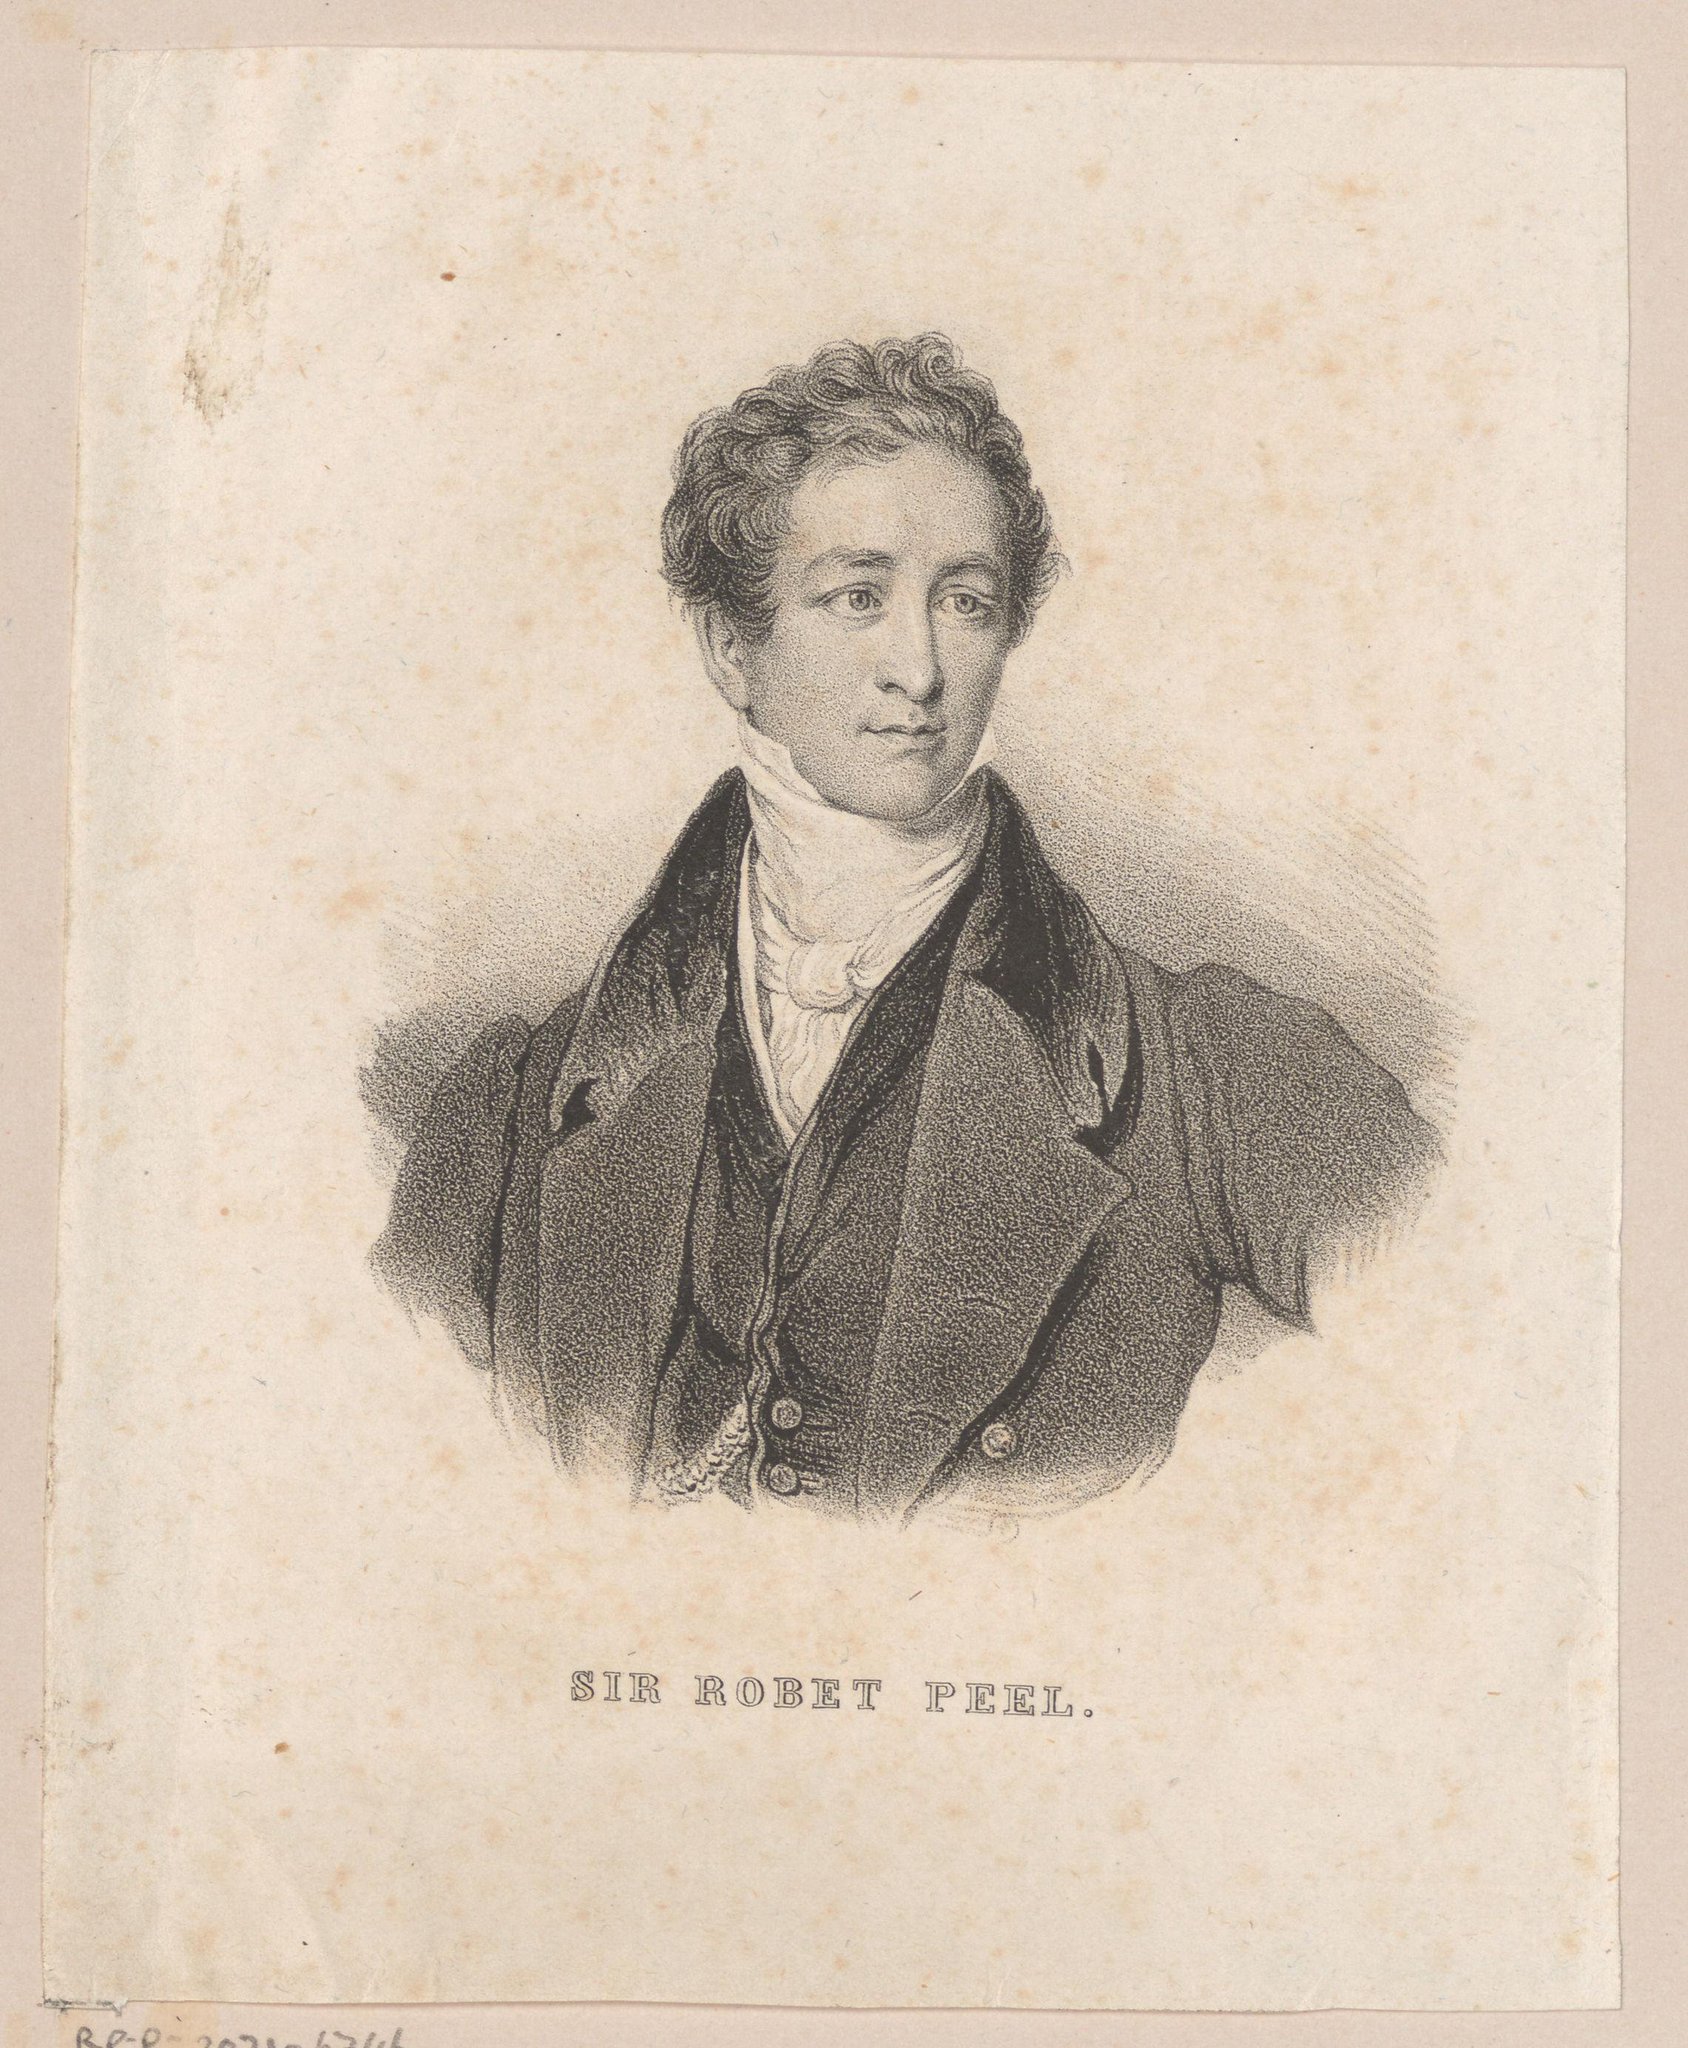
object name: print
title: Portret van Robert Peel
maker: Anonymous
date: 1820-1899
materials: paper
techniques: lithograph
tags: london, adult man, historical persons